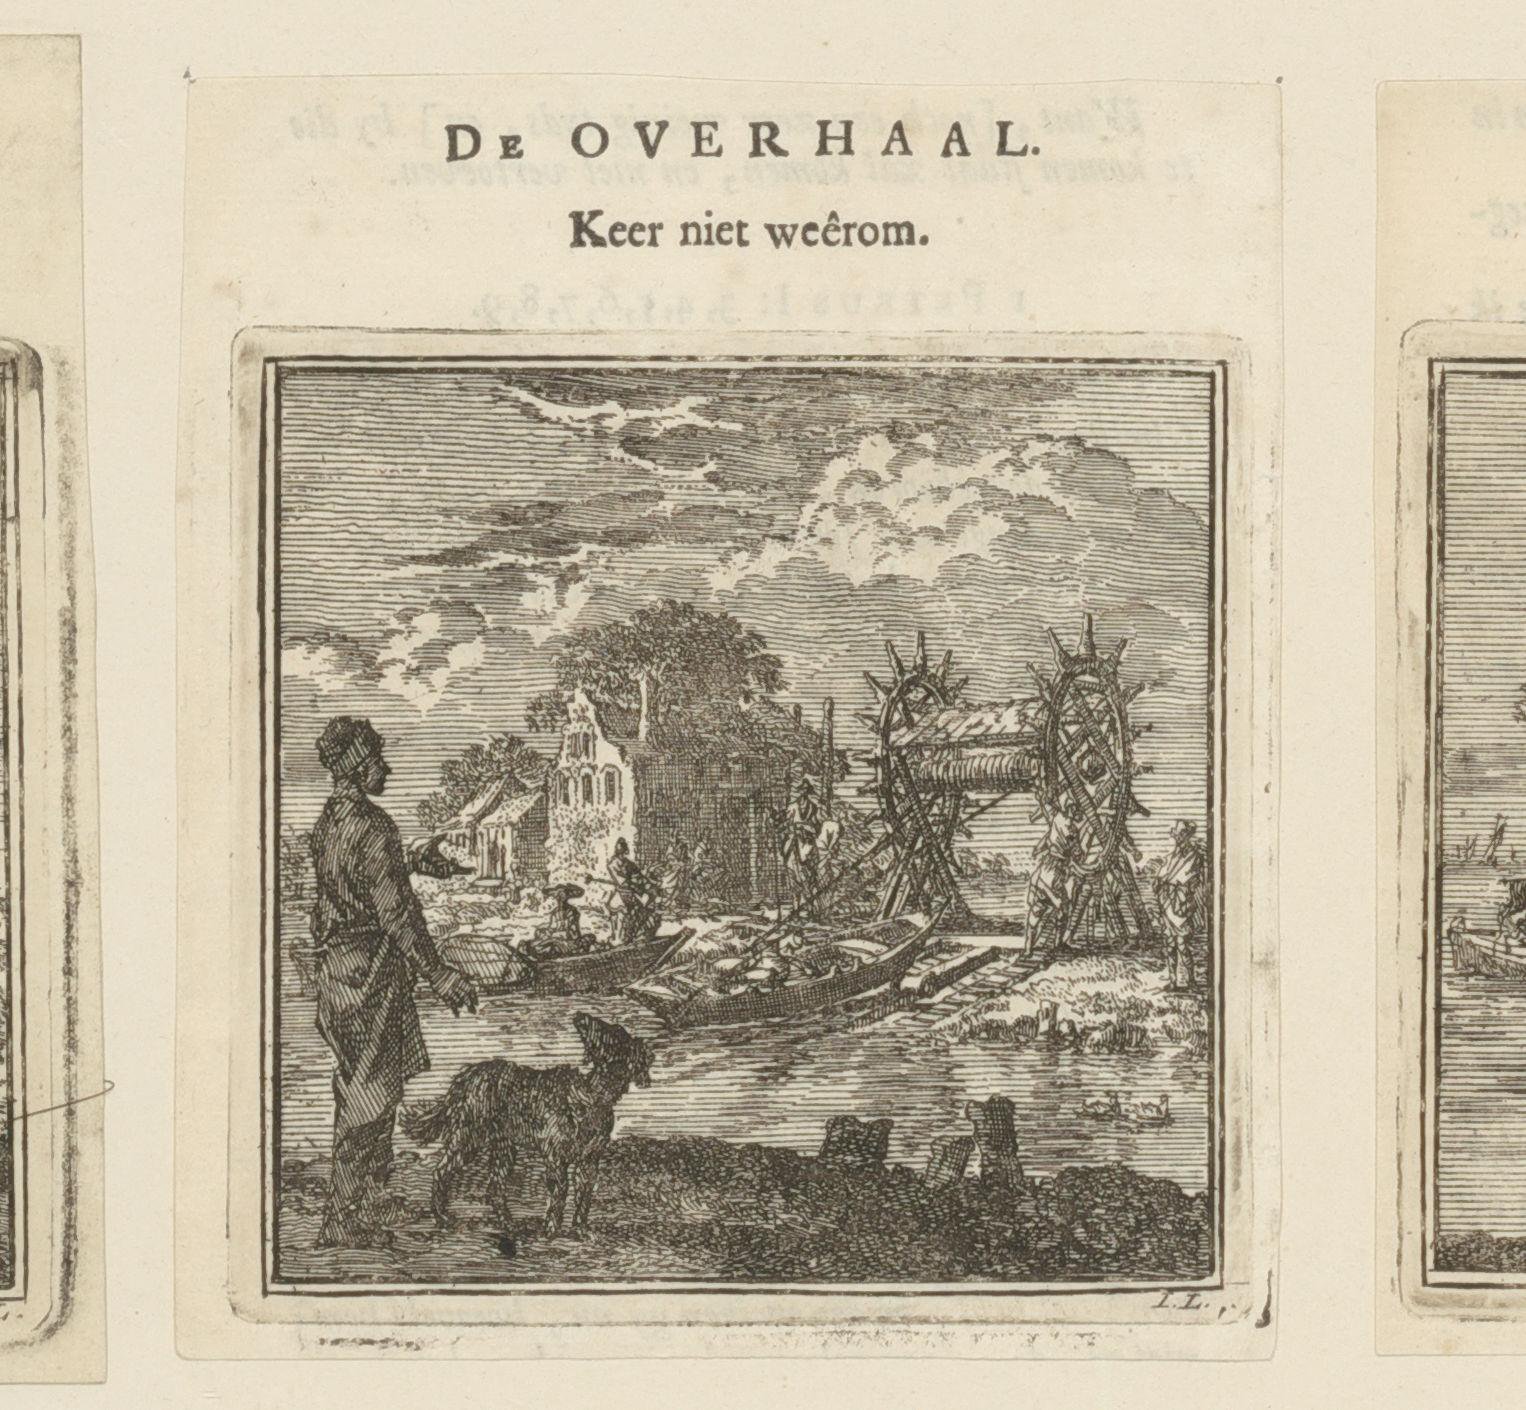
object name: book illustration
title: De Overhaal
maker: jan luyken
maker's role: draughtsman, print maker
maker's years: 1649-1712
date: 1711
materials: paper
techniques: etching, letterpress printing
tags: ships (in general), rolling bridge (dutch: 'overtoom')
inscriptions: collector's mark: Lugt 1641, stamp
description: Prent uit: Luyken, Jan. De Bykorf des Gemoeds. Amsterdam: Pieter Arentsz. II (wed.) en Cornelis van der Sys, 1711, p. 378.